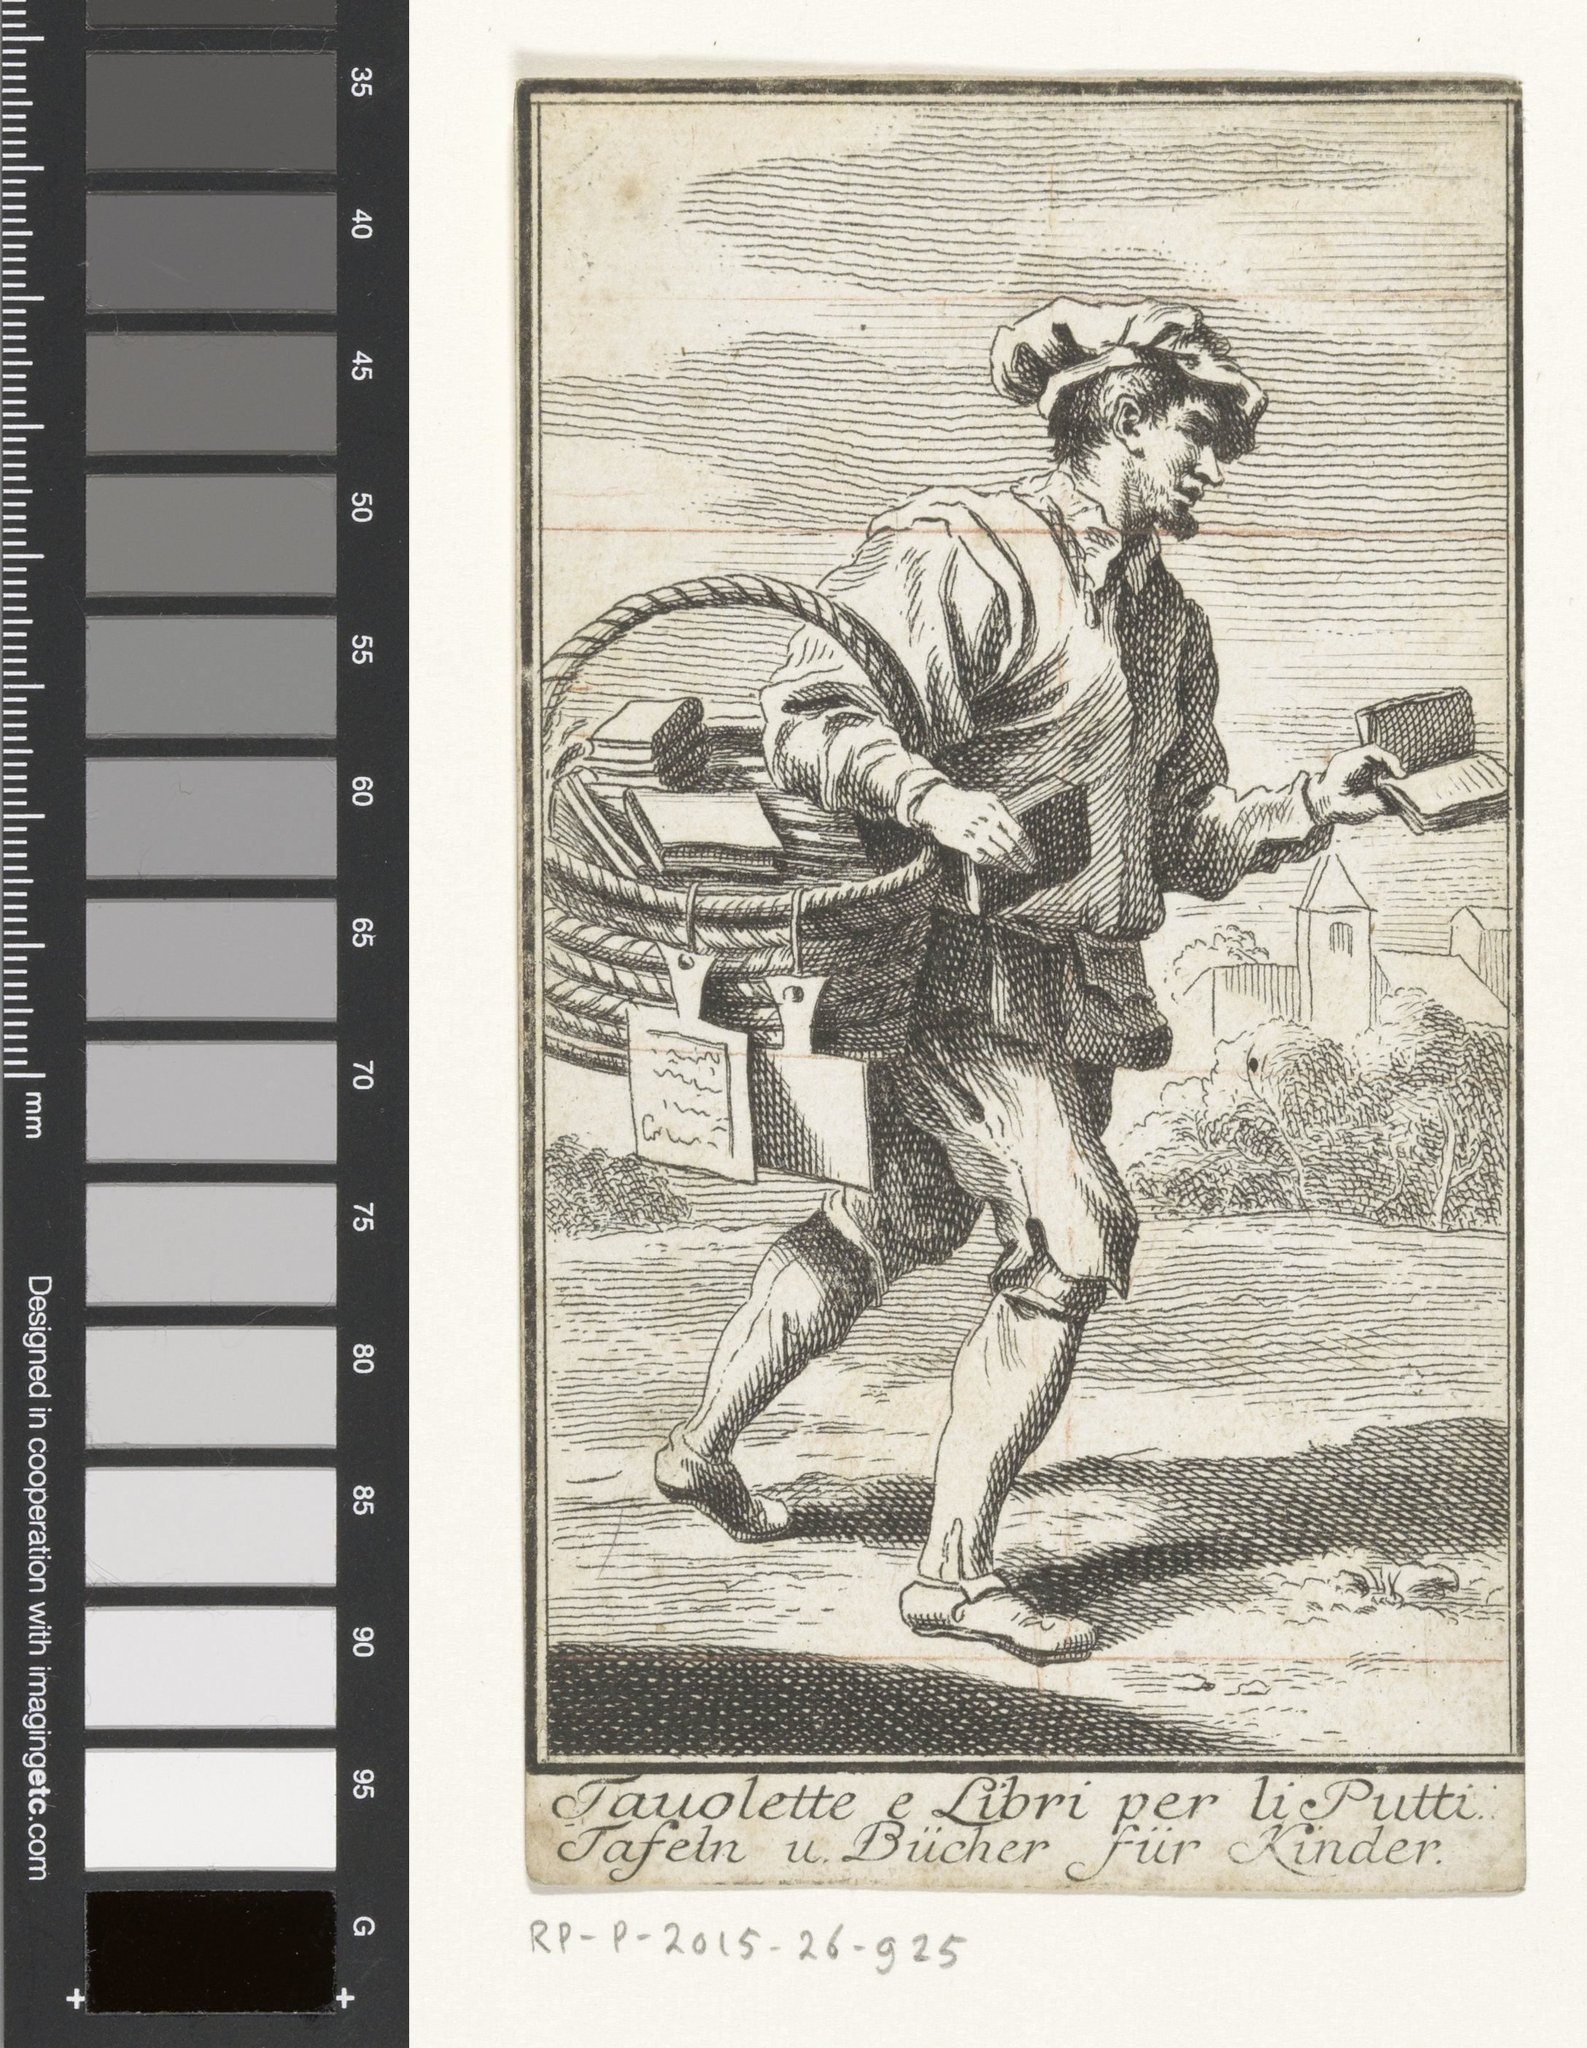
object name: print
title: Tavolette e libri per li putti / Tafeln u. Bücher für Kinder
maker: Anonymous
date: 1700-1799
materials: paper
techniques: engraving, etching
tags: writing tablets, book, book-shop, bookseller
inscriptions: collector's mark: Lugt 4779, collector's mark: Lugt 2228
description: Een man in een landschap met aan zijn rechterarm een mand met boeken. Aan de mand hangen twee schrijfplankjes.